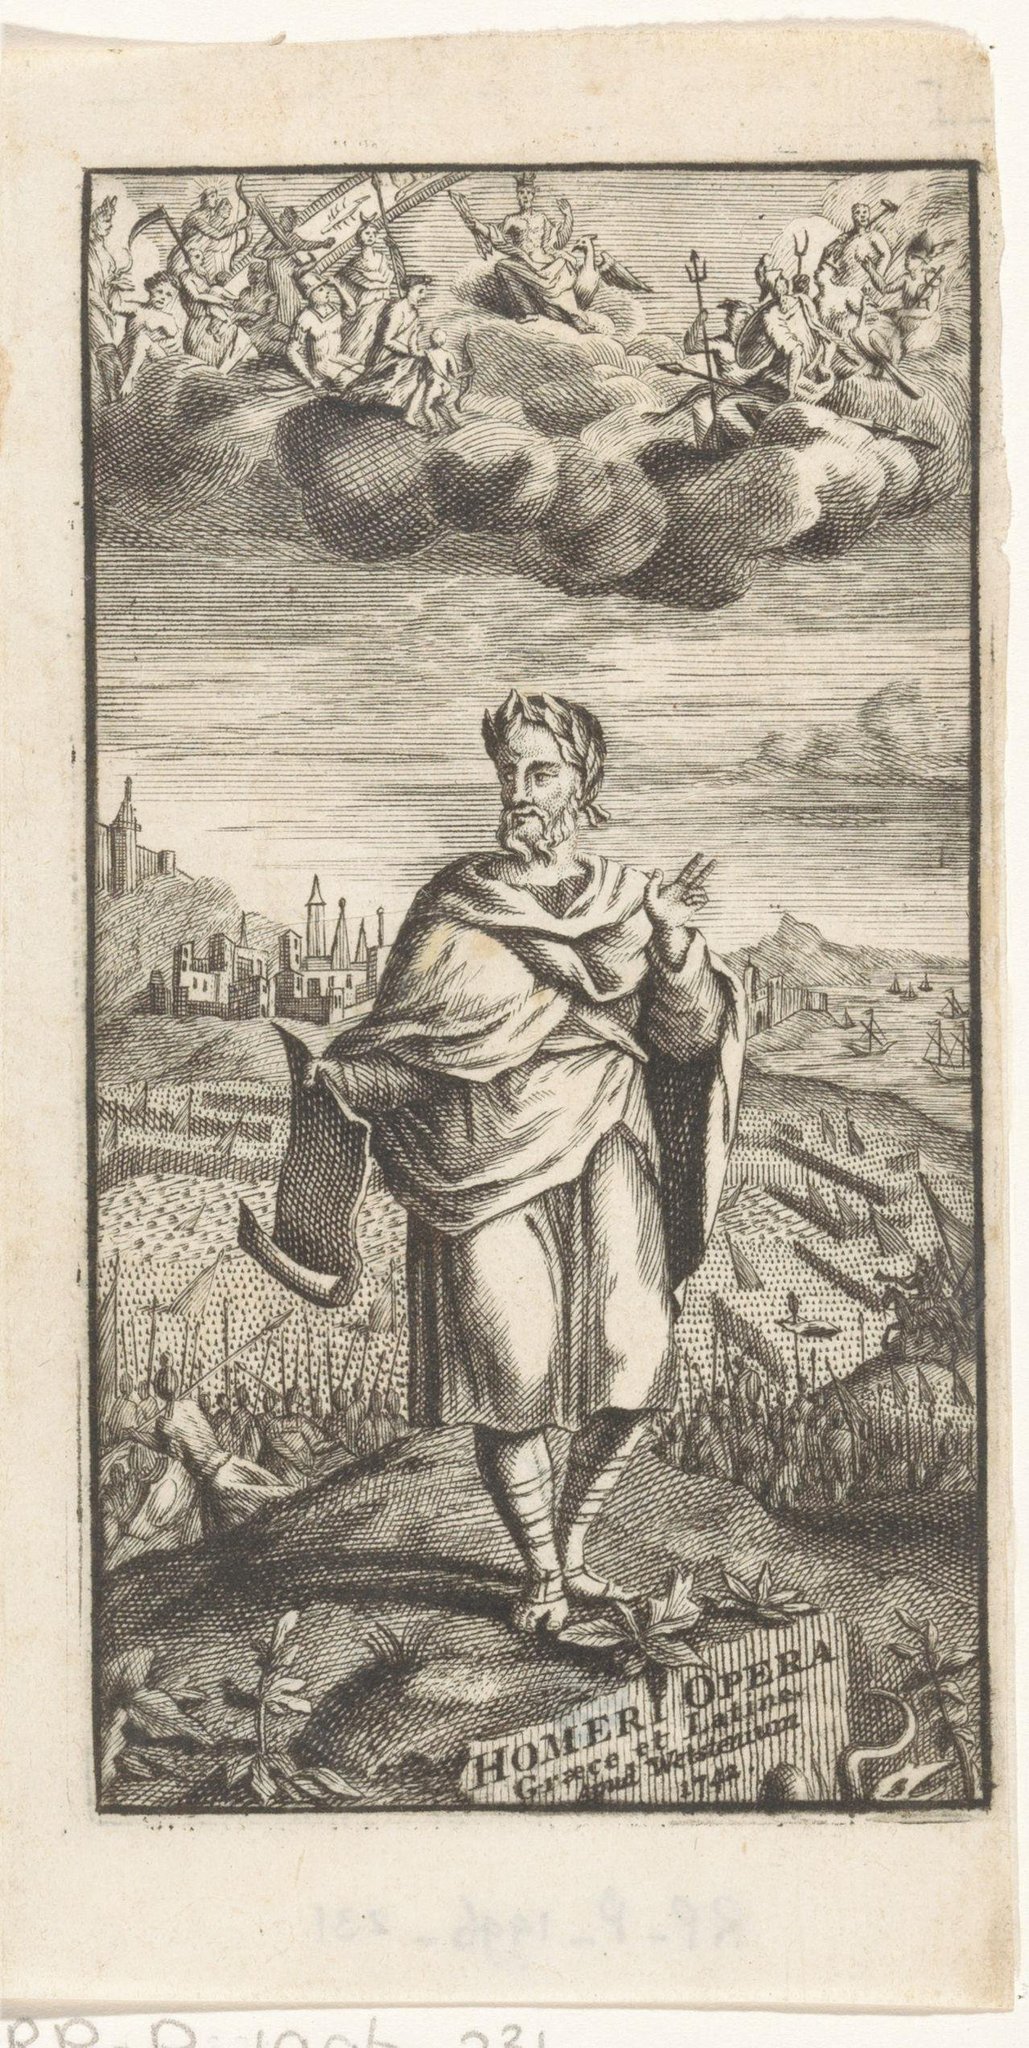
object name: print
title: Homerus met papierrol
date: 1742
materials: paper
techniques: engraving, etching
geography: amsterdam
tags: the olympian gods together: jupiter, juno, neptune, ceres, apollo, diana, mars, venus, mercury, minerva, vulcan, vesta (or bacchus), (story of) homer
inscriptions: collector's mark: Lugt 2760, collector's mark: Lugt 2228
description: Homerus staat op een berg met een papierrol in zijn hand. Op de achtergrond twee legers en in de verte een stad. In de wolken de Olympische goden.